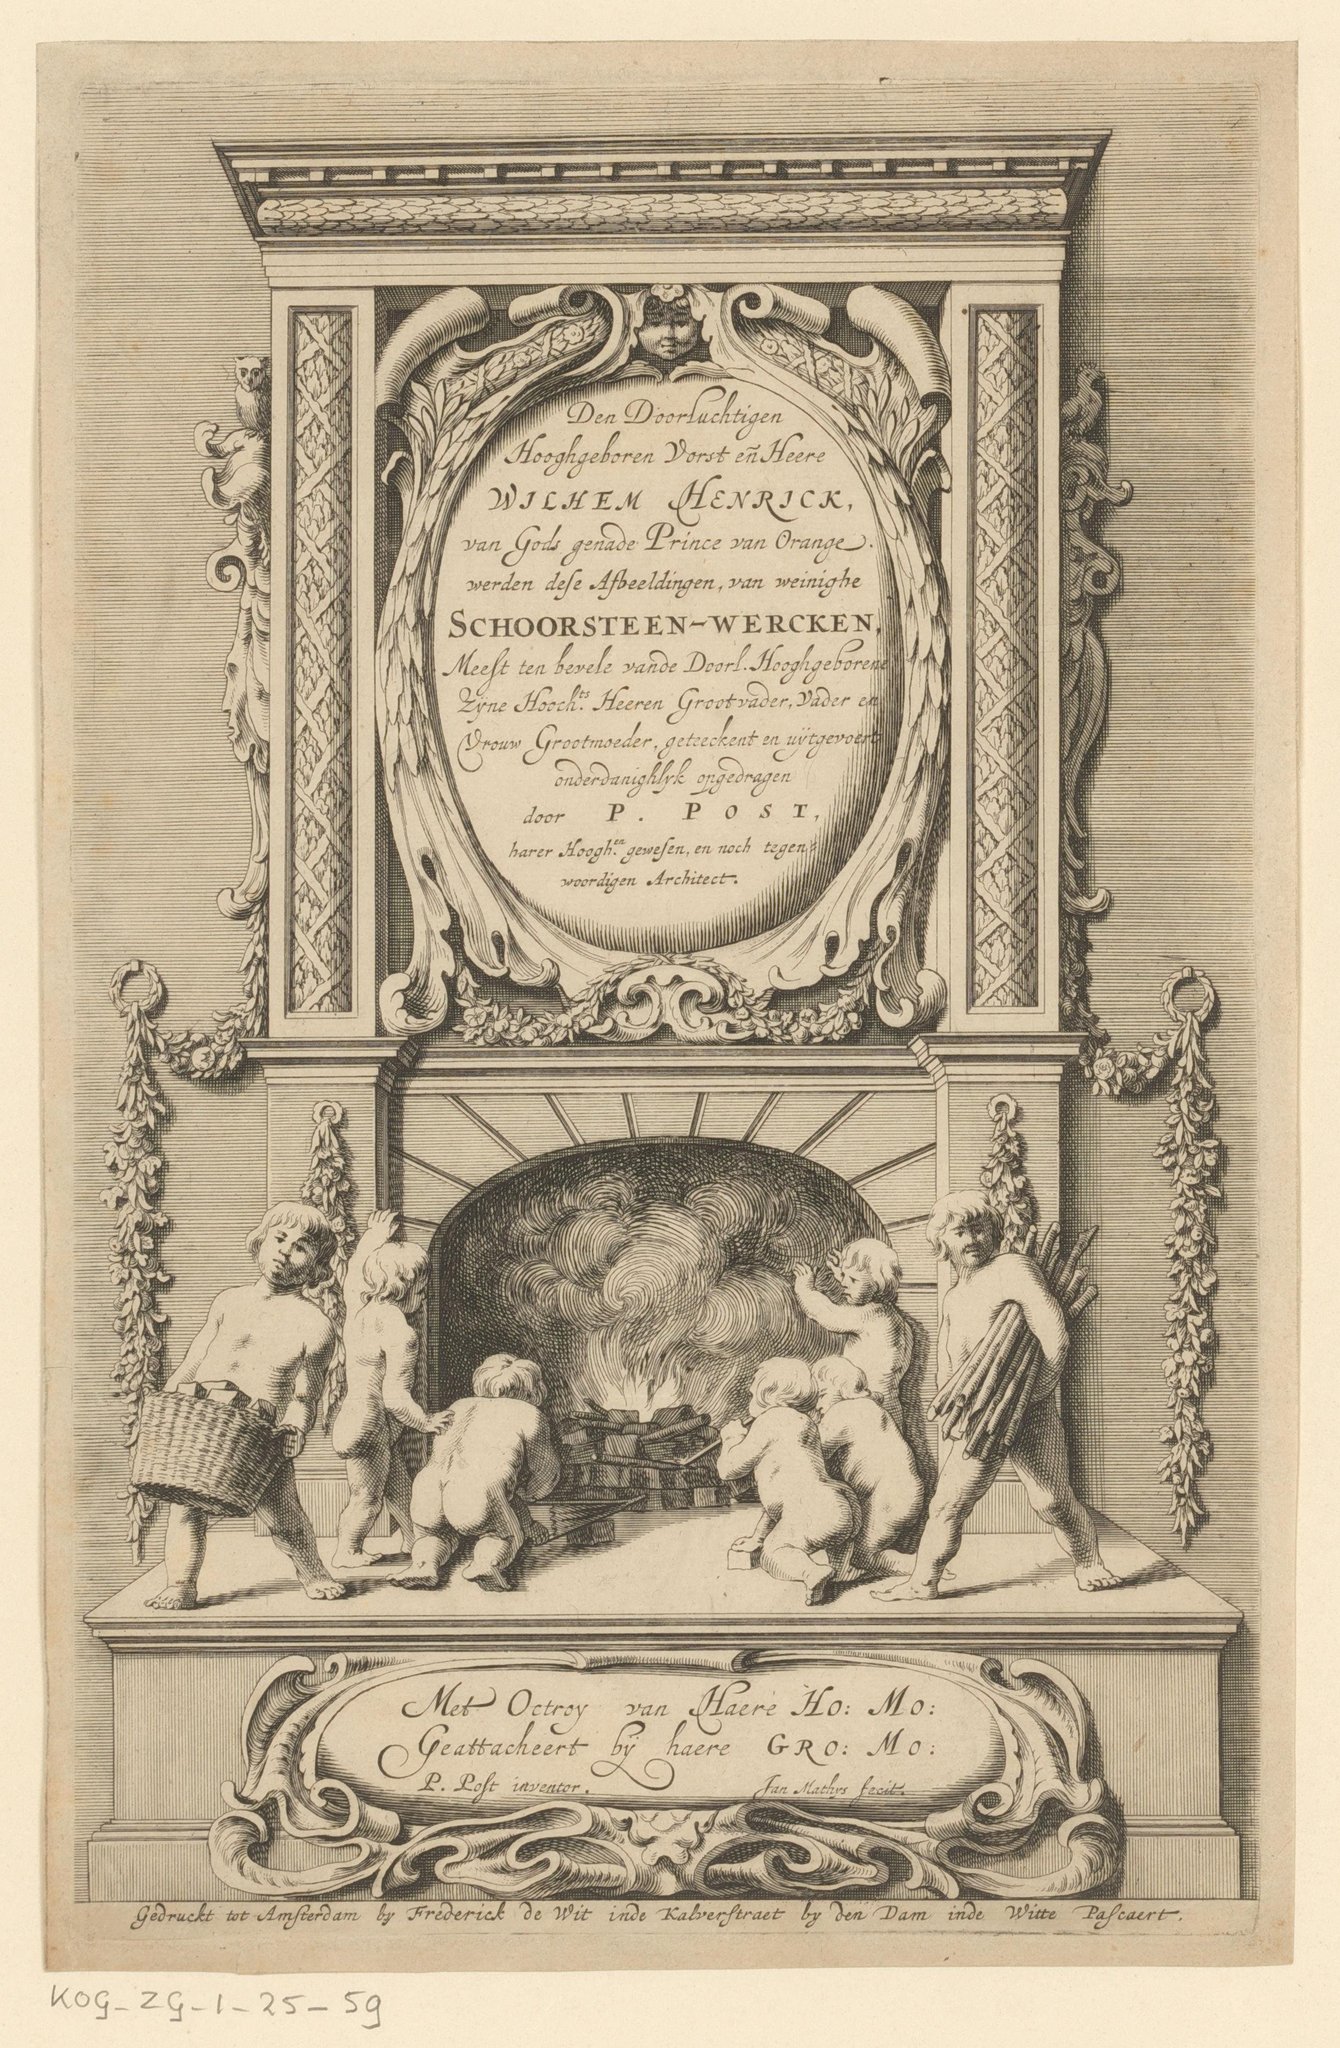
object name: titelprent, frontispice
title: Den Doorluchtigen Hooghgeboren Vorst en Heere Wilhem Henrick (...)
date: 1669-1706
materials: paper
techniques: engraving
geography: amsterdam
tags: chimney, chimney ornaments, chimney-piece, mantelpiece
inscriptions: collector's mark: Lugt 1641, : ‘Met Octrooy van hare HO: MO: Geattacheert bij hare GRO: MO:’, collector's mark: Lugt 1641a, stamp:, stamp:, stamp:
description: Titelprent is onderdeel van een serie bestaande uit een titelprent en 22 vervolg prenten. De serie is voor het eerst uitgegeven door Pieter Jansz. Post in Den Haag of Rotterdam. De huidige (tweede staat) is uitgegeven door Frederik de Wit tussen 1669 en 1706. De volgorde van de prenten is in deze serie veranderd. De prenten zijn een derde keer uitgegeven door Pieter van der Aa in 1715 te Leiden. Hier is de volgorde wederom aangepast.